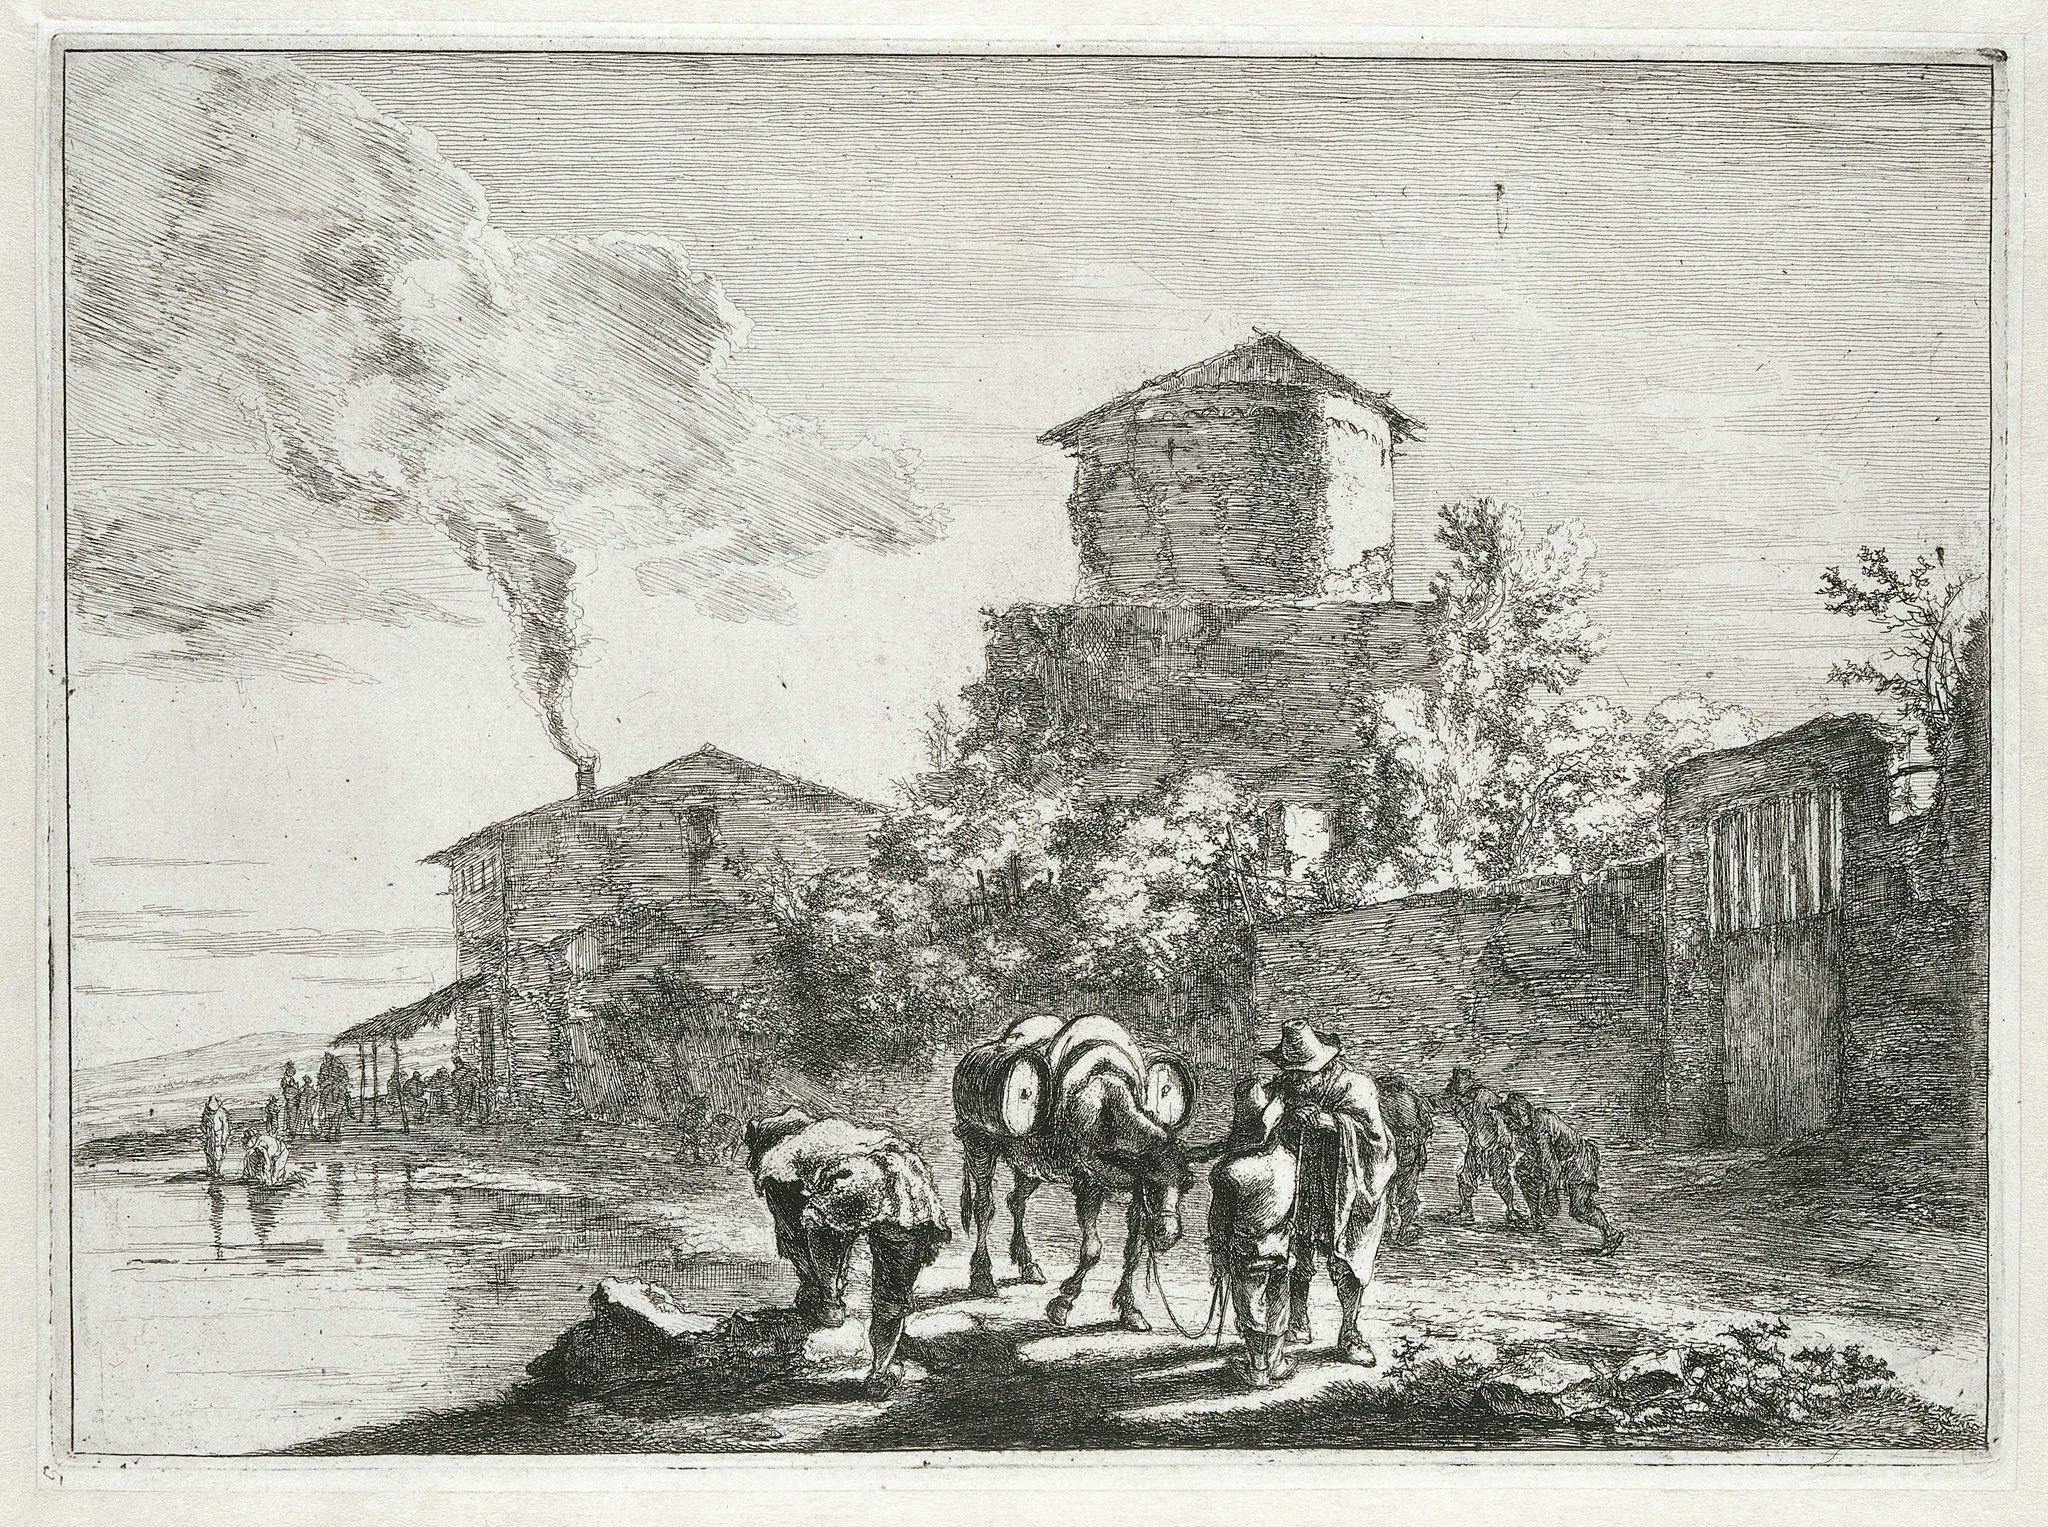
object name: print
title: Landschappen in de omgeving van Rome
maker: jan both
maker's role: draughtsman, painter, print maker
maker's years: 1618-1652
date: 1644-1652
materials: paper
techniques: etching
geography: utrecht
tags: mule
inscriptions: number: ‘5’, collector's mark: Lugt 10